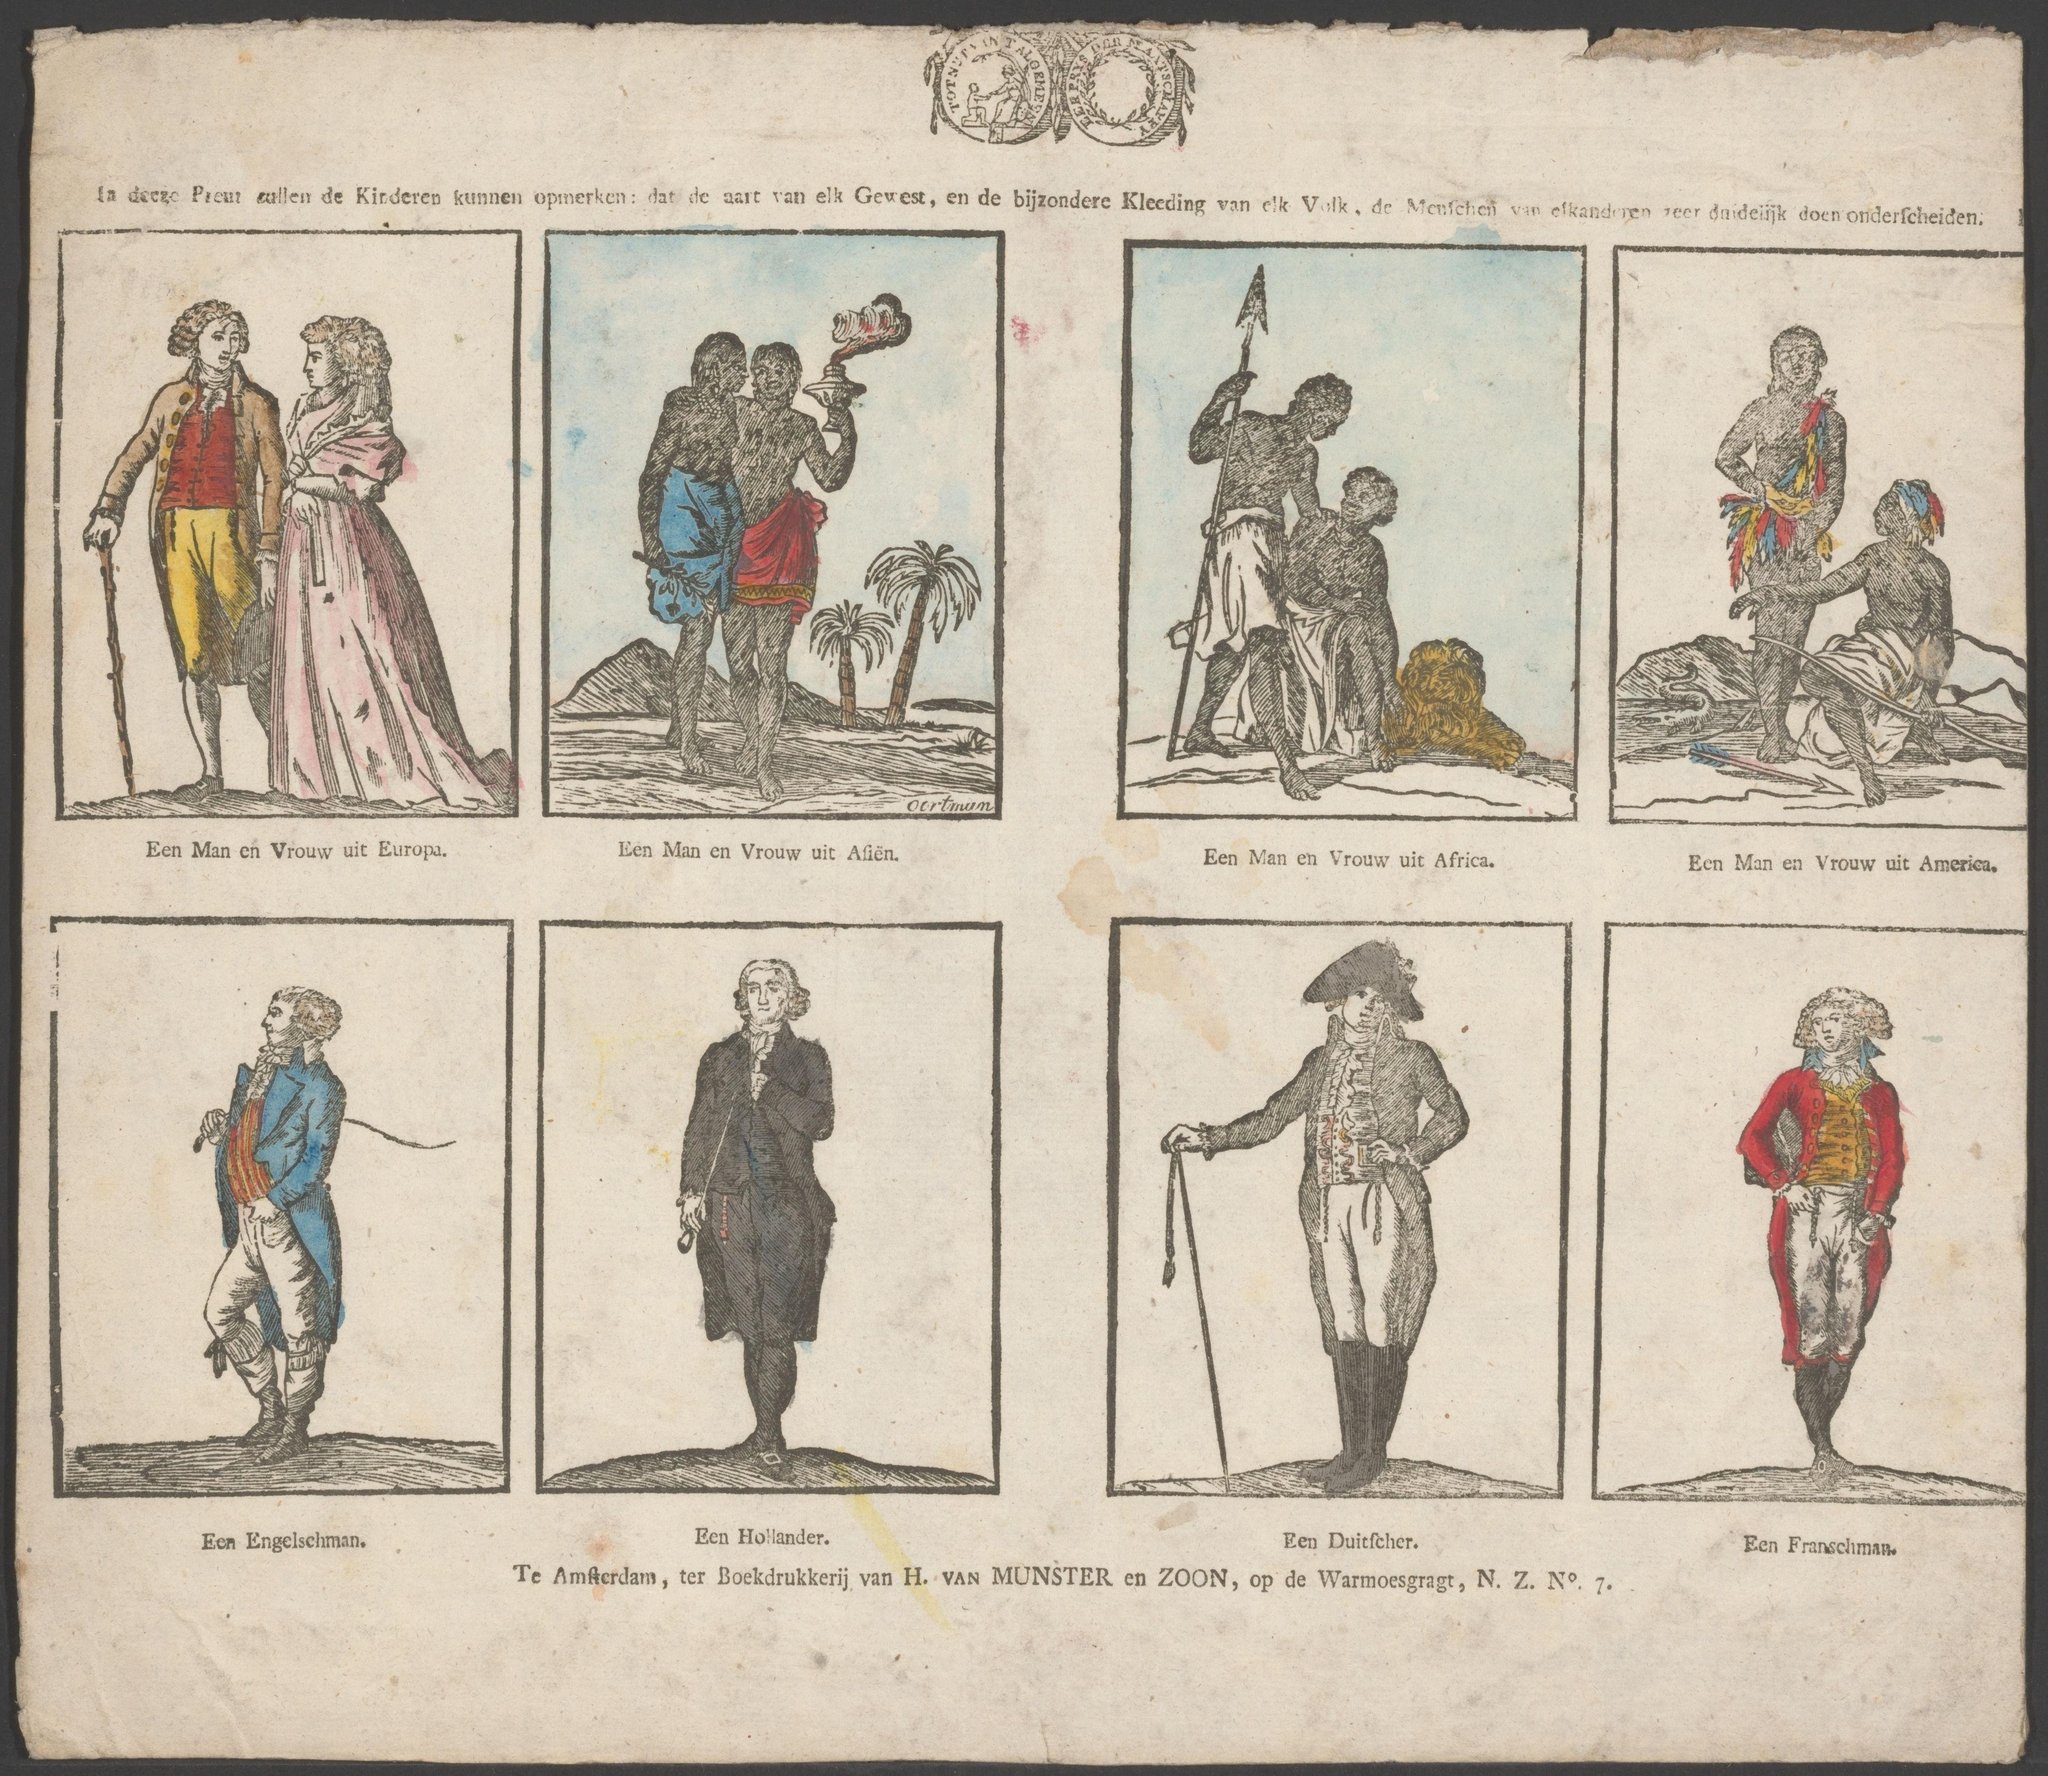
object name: print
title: In deeze prent zullen de kinderen kunnen opmerken: dat de aart van elk gewest, en de bijzondere kleeding van elk volk, de menschen van elkanderen zeer duidelijk doen onderscheiden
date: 1811-1829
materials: paper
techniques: hand coloring, letterpress printing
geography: amsterdam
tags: historical costume, folk costume, regional costume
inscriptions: stamp, collector's mark: Lugt 1641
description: Blad met acht voorstellingen van de kleding van verschillende nationaliteiten en volkeren. Bovenaan het zegel van de Maatschappij tot Nut van 't Algemeen. Onder elke afbeelding een onderschrift. Onderwerpsrubrieken binnen de Atlas Zeden en Gewoonten: Zeden en gewoonten in engeren zin, Des menschen begin, midden en einde, Kinderprenten opgeplakt op karton.